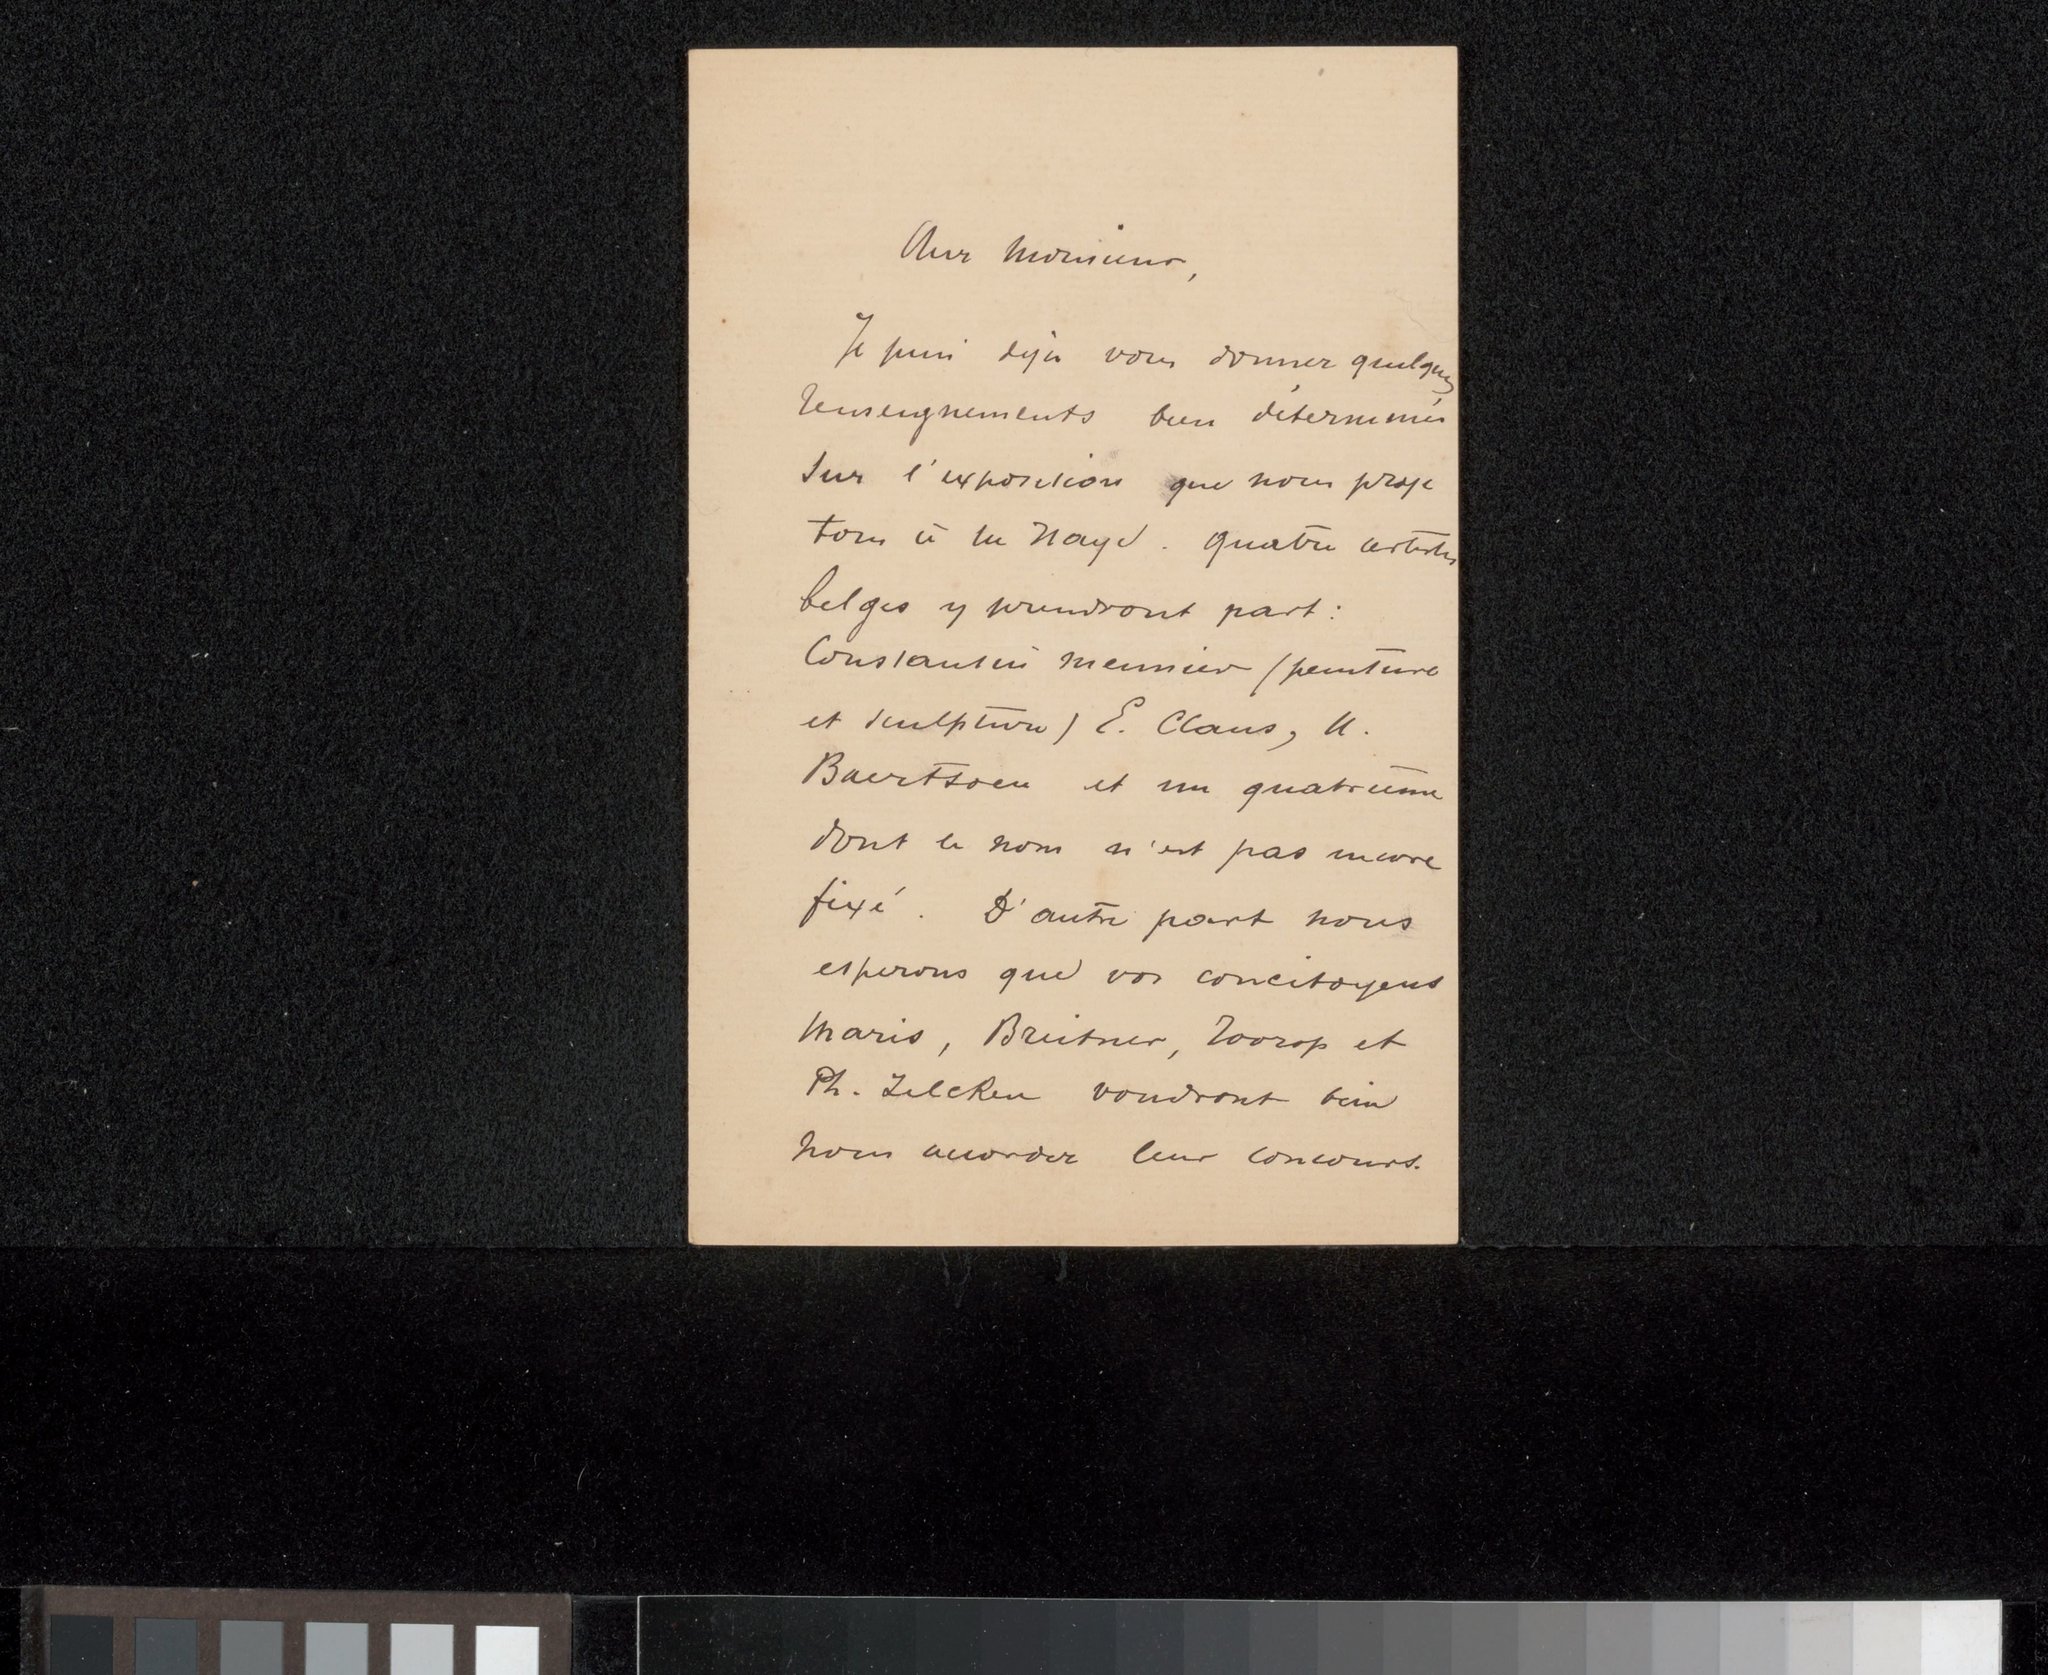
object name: letter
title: Brief aan Philip Zilcken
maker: albert baertsoen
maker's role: draughtsman, print maker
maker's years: 1866-1922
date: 1876-1922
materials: ink, paper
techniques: pen, writing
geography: oostende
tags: the hague, painter, draughtsman, philip zilcken, temporary exhibition, 'salon'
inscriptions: watermark, collector's mark: ‘RPK’